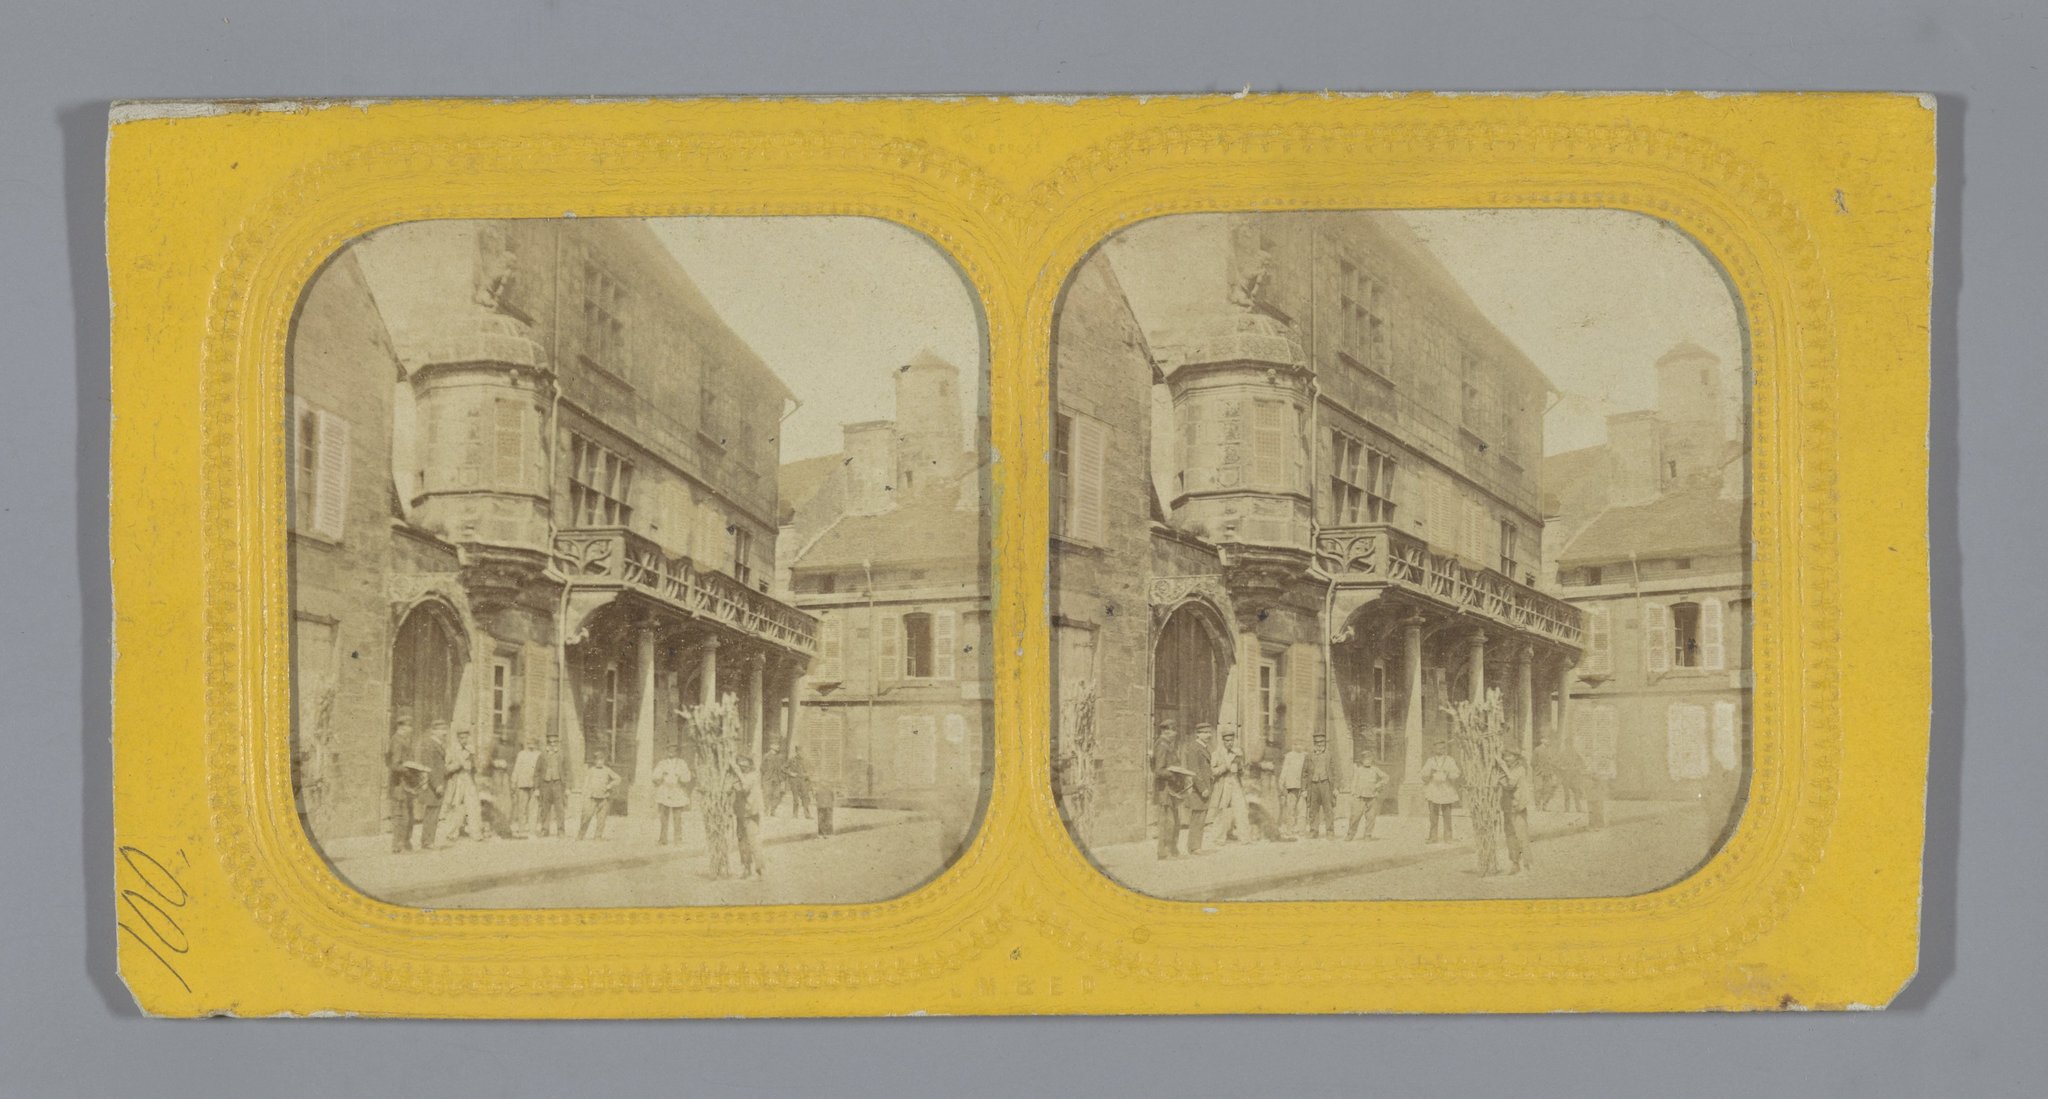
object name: tissue stereograph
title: Luxeuil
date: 1855-1875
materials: cardboard, paper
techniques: albumen print, hand coloring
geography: luxeuil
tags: hôtel, i.e. small palace in city, street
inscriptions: number: ‘100’